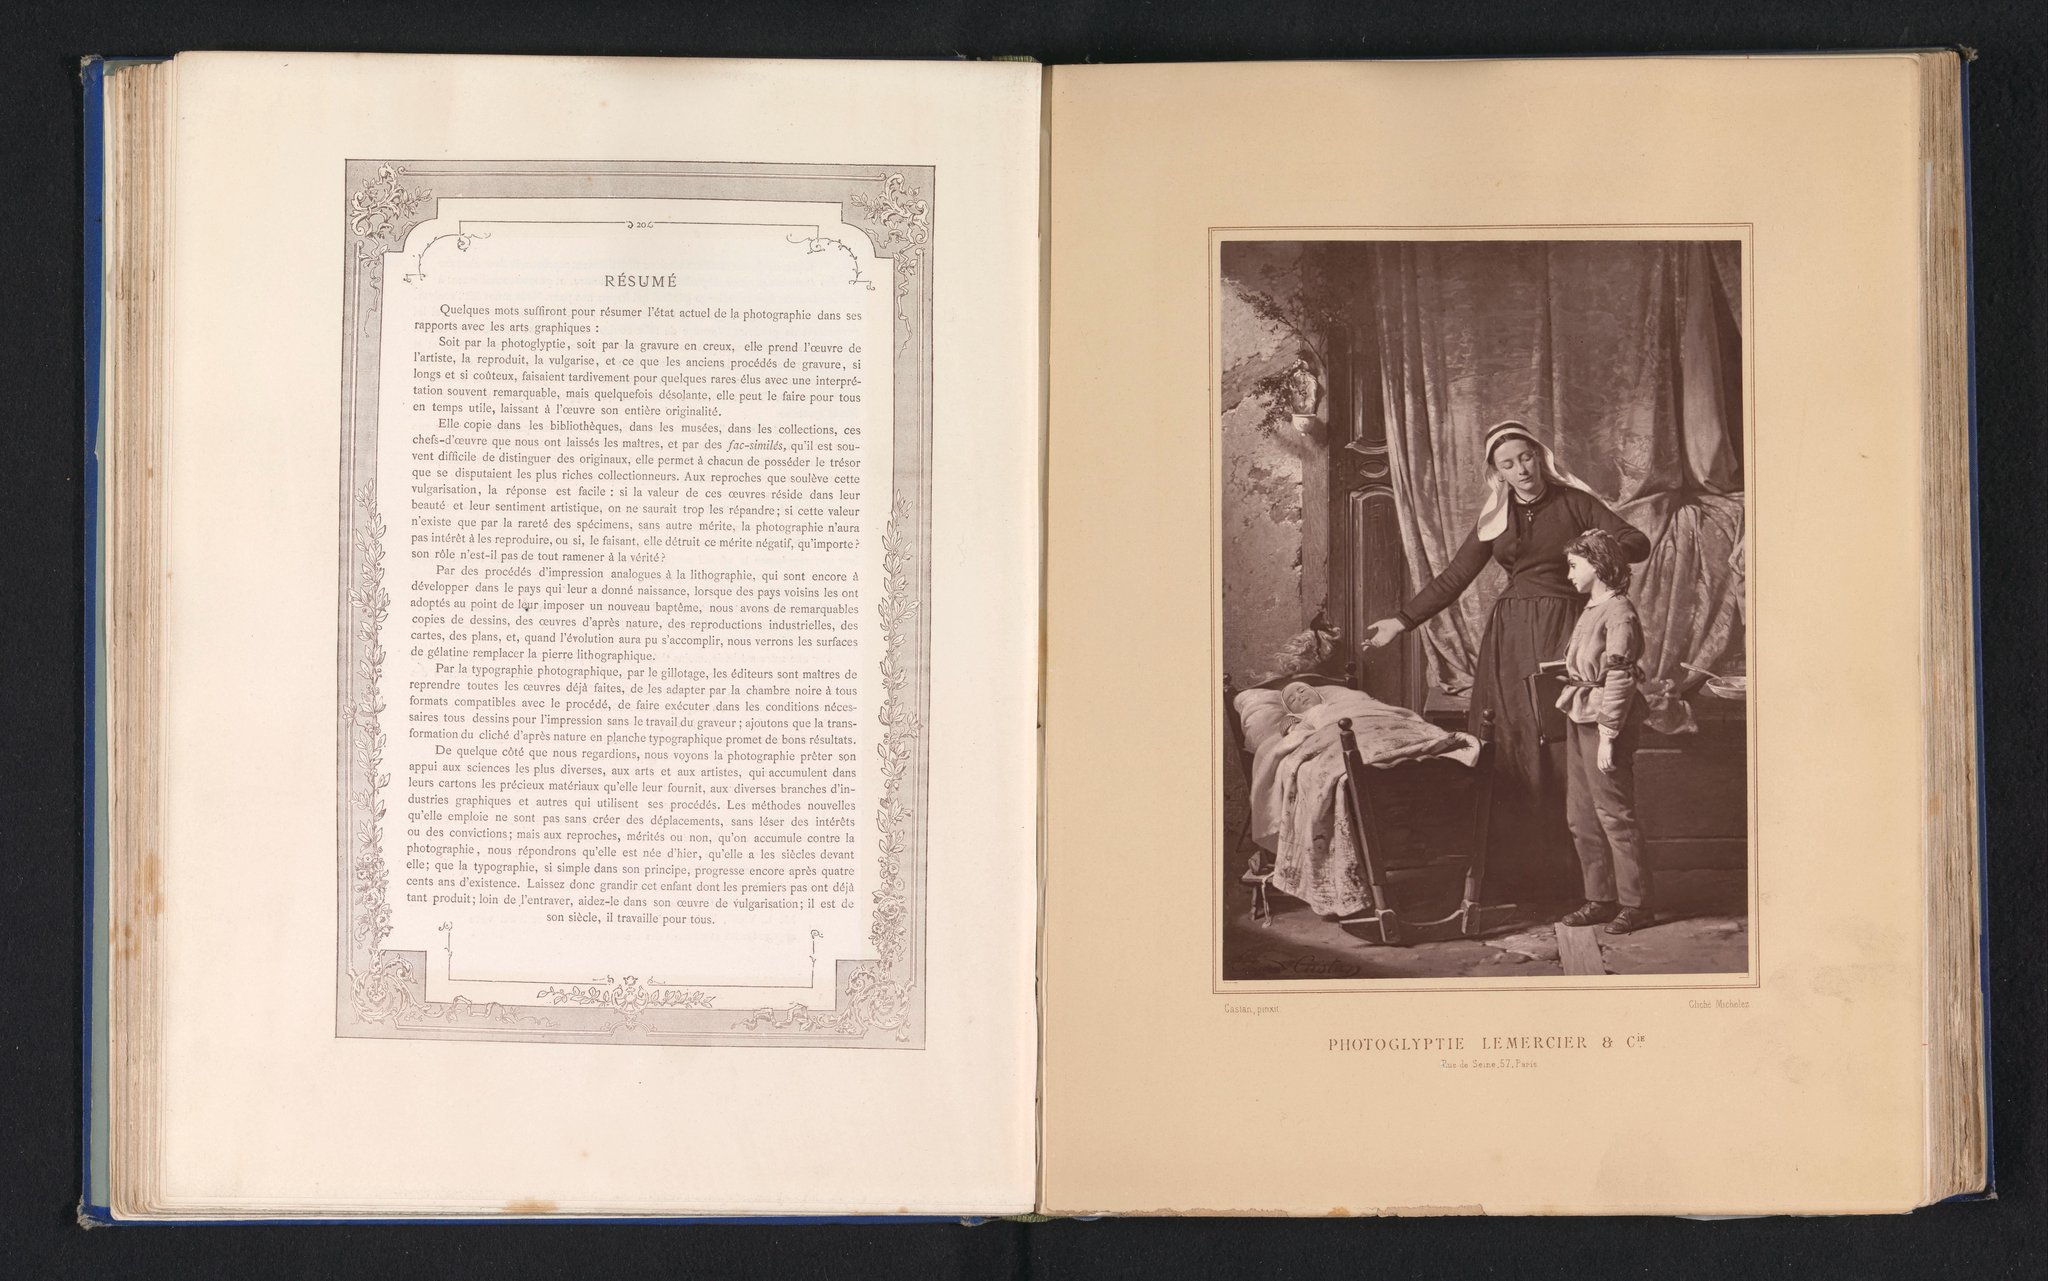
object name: photomechanical print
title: Fotoreproductie van een schilderij, voorstellende een moeder en een kind voor een slapend kind in bed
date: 1871-1881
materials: paper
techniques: woodburytype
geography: france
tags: watching a sleeping child, interior ~ representation of a building, mother and child(ren), woman and child(ren) (family group)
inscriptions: name: ‘Photoglyptie Lemercie & Cie Rue de la Seine, 57, Paris’